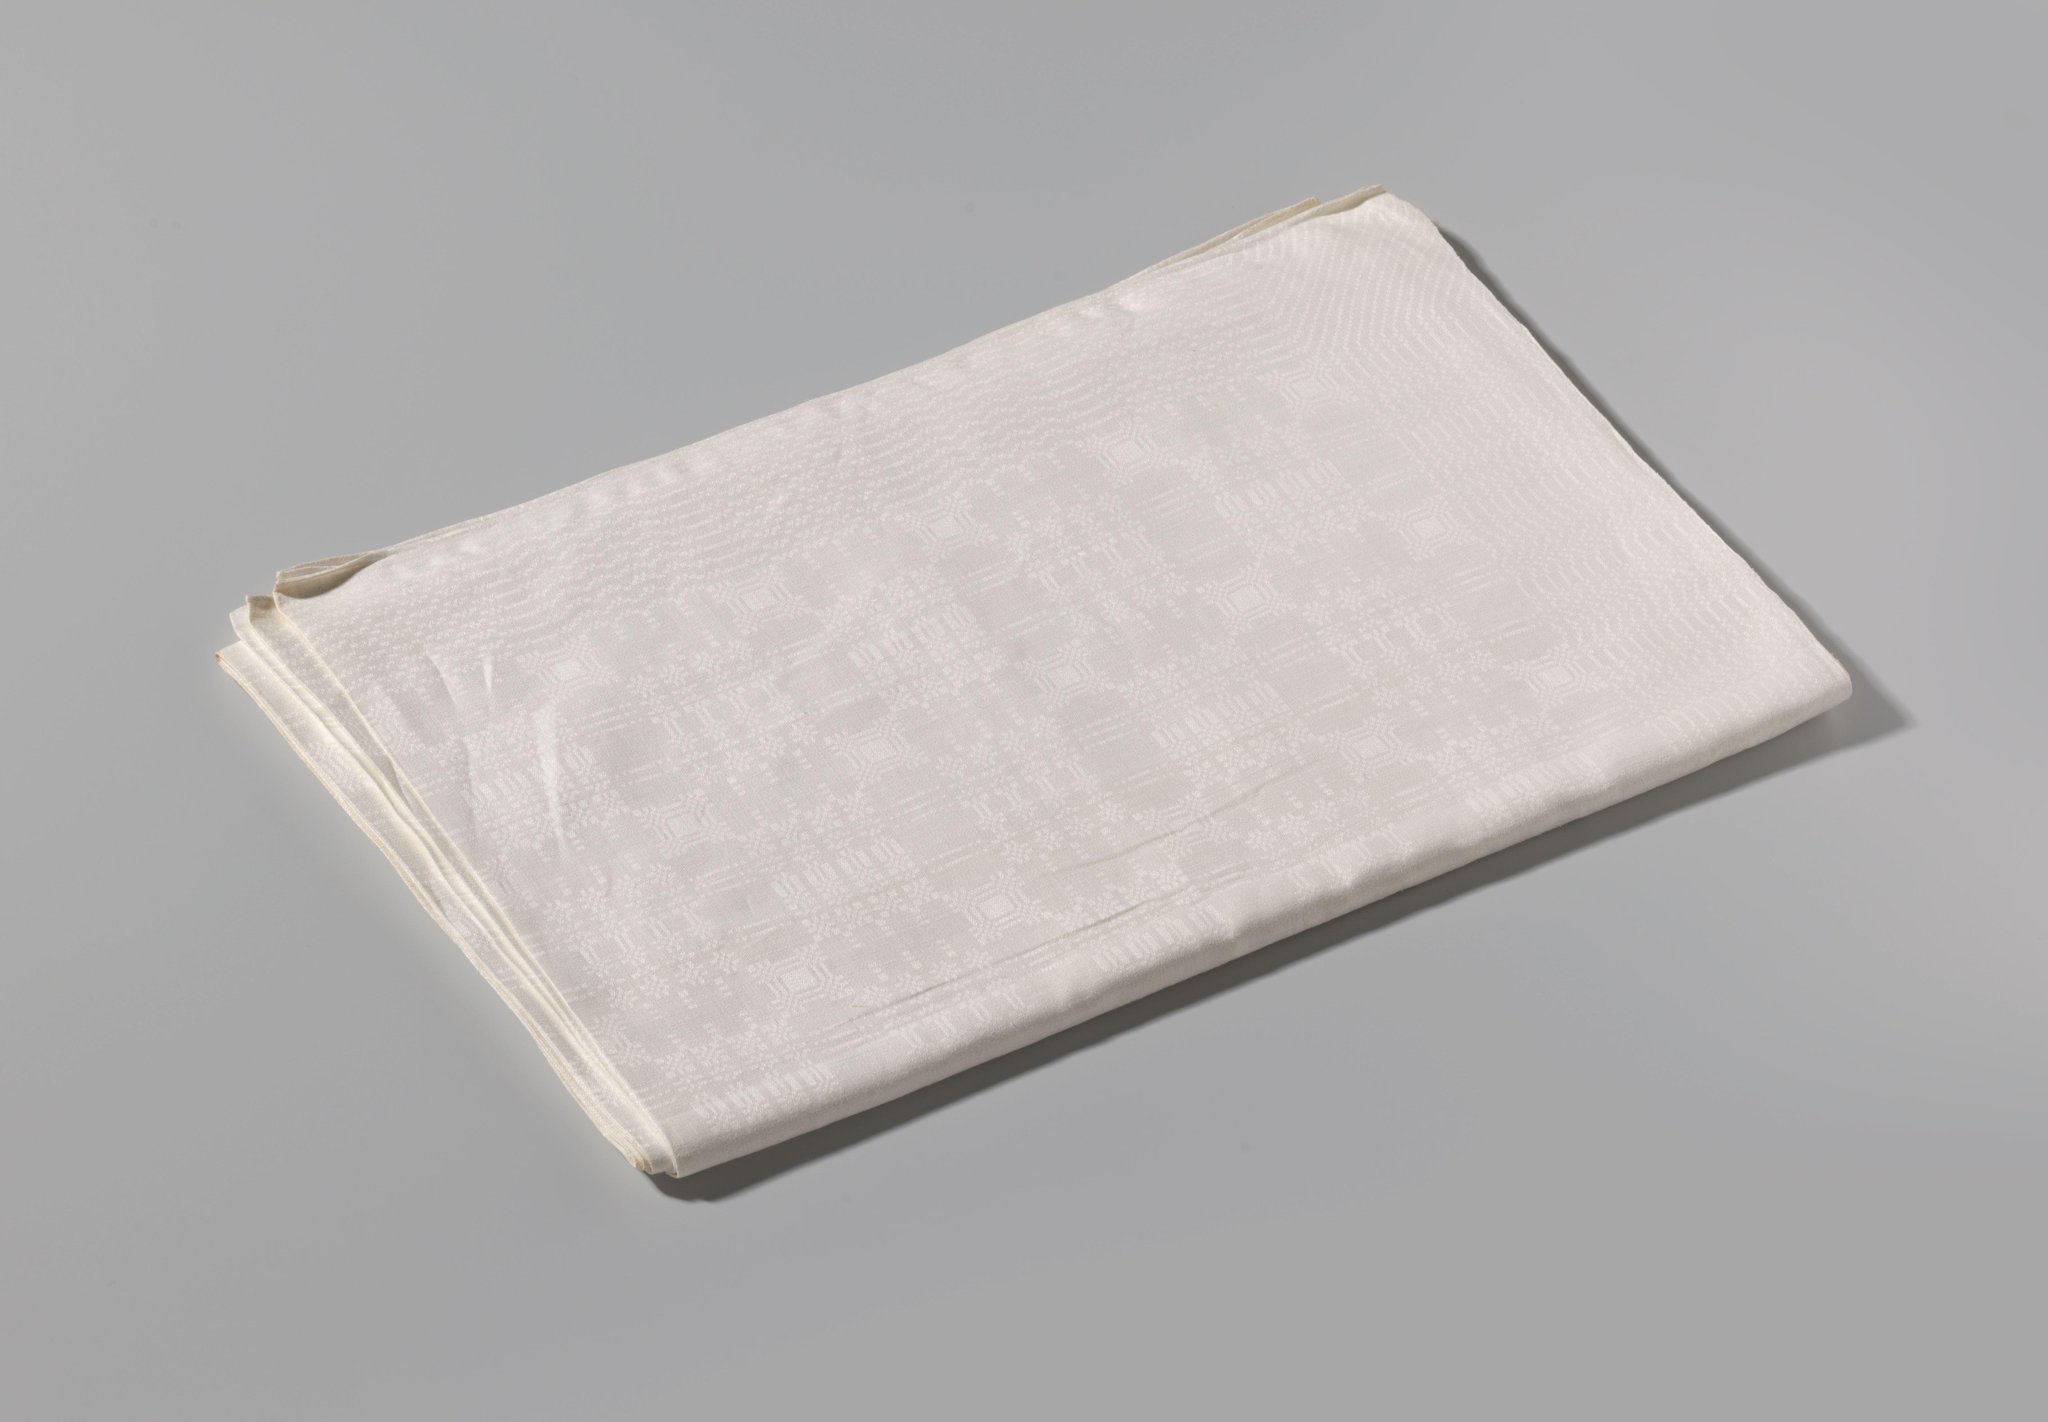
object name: tablecloth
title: Tafellaken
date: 1800-1899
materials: linen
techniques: peeled fabric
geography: netherlands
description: Wit linnen tafellaken met een pellen patroon, merk HP 4 en K p poon.